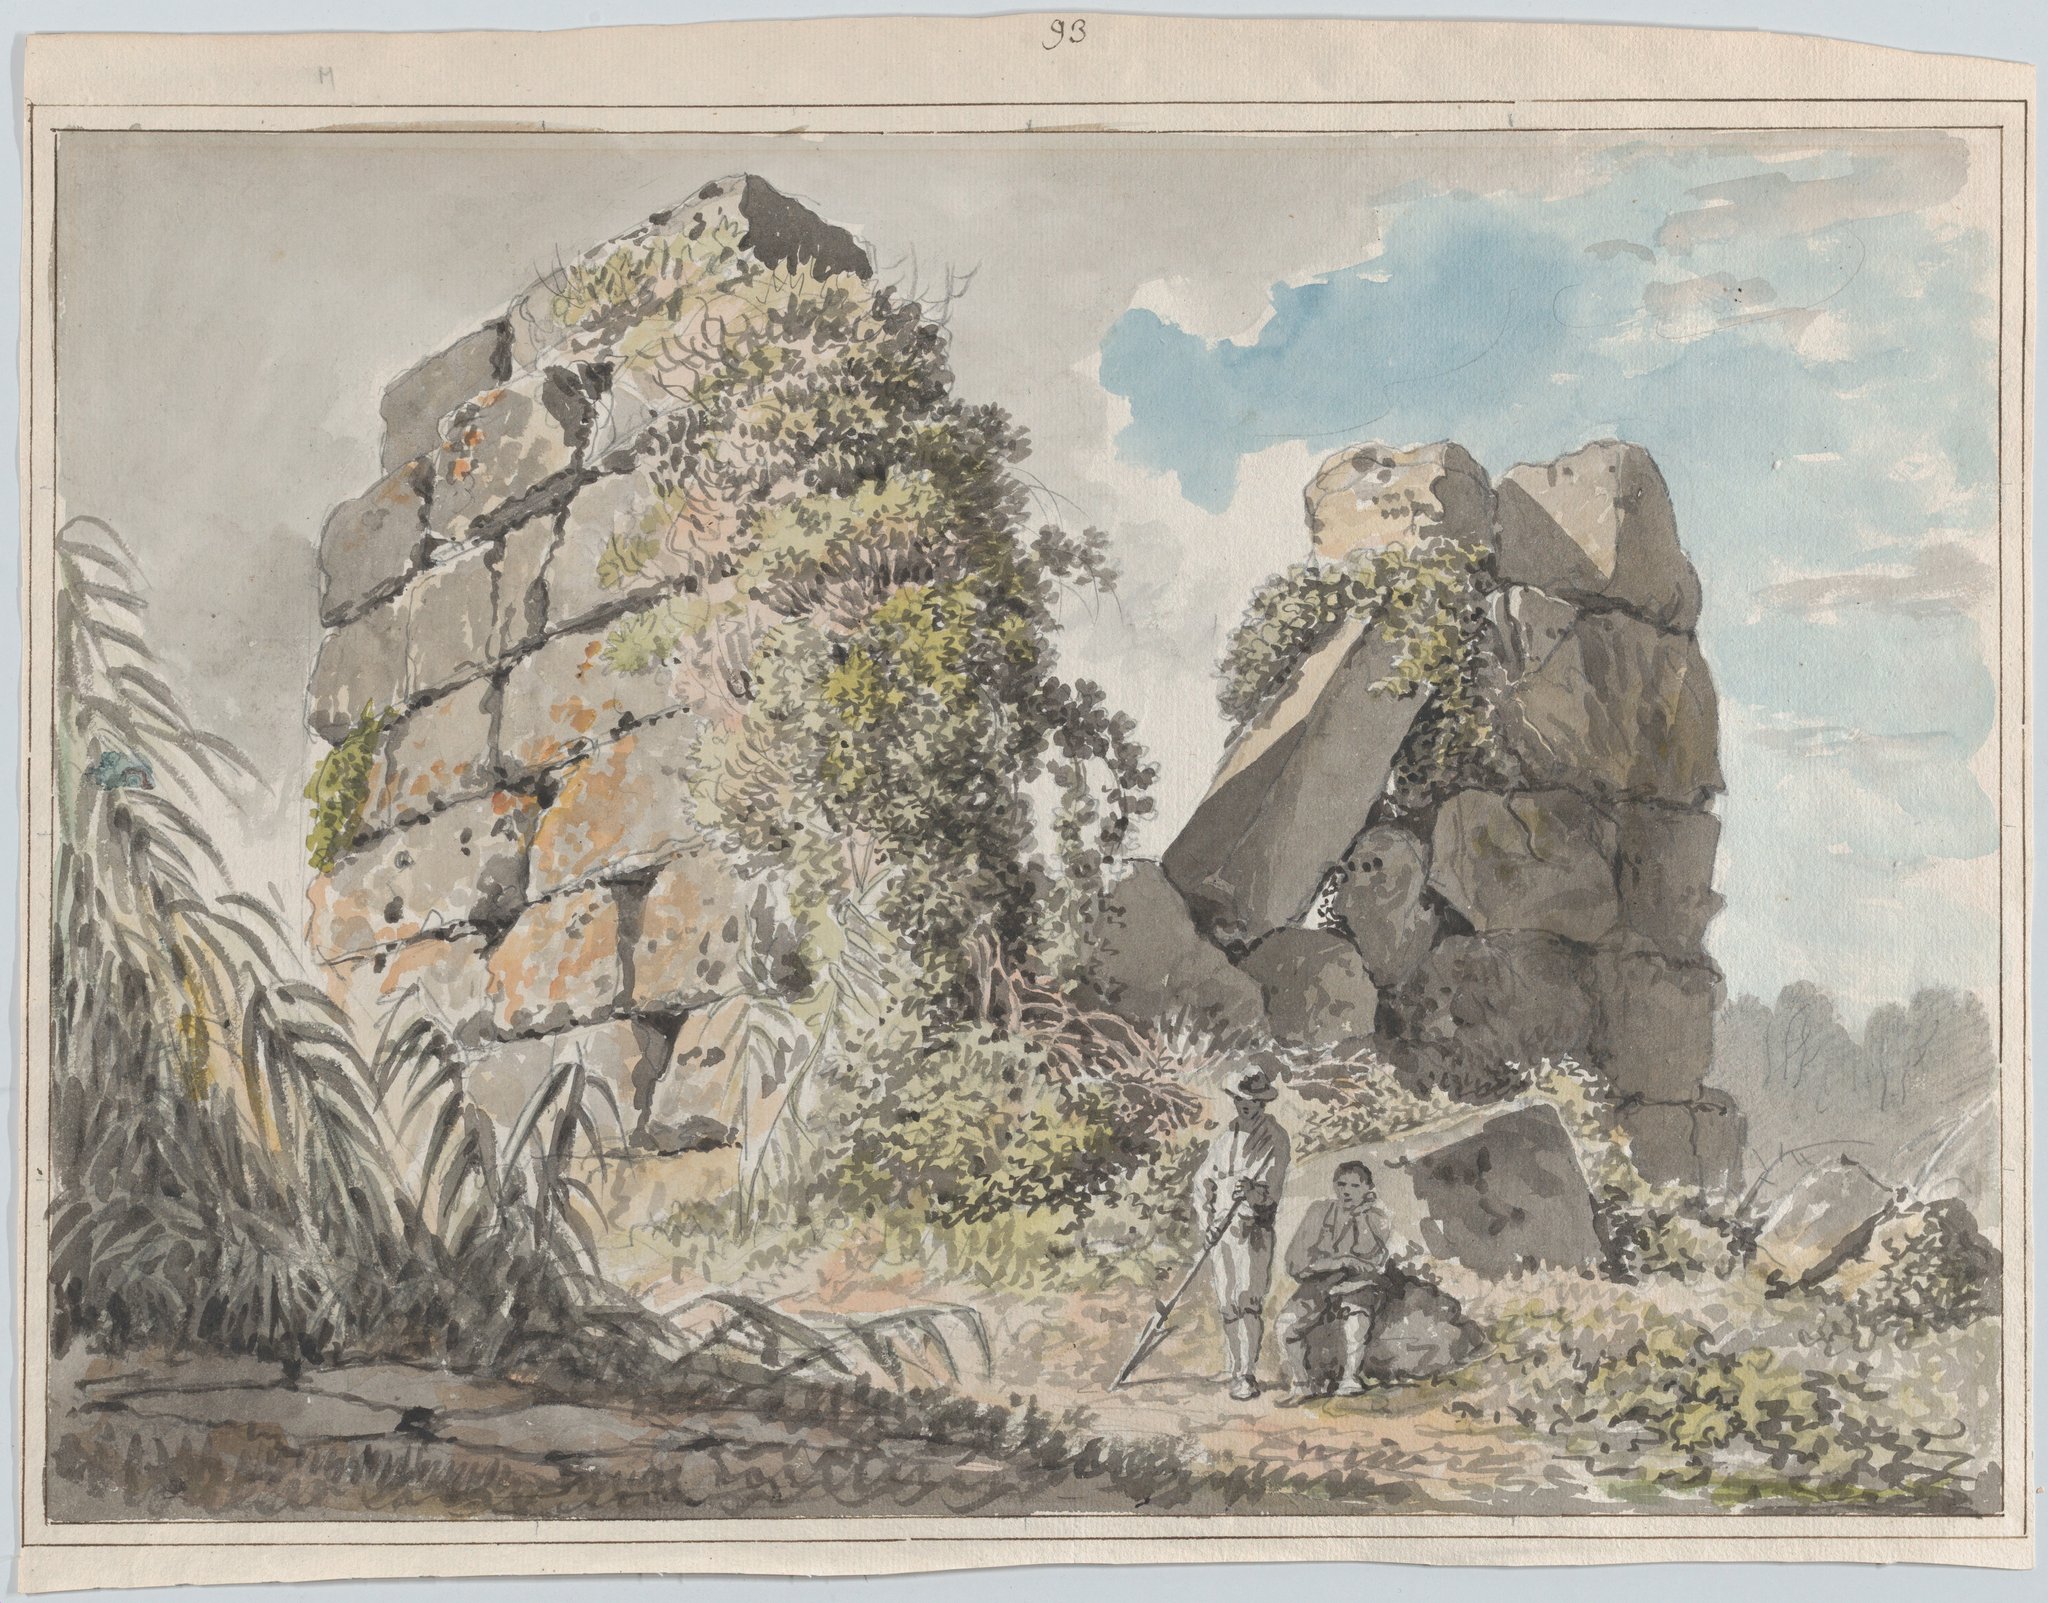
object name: drawing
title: Ruins on the Right of the Via Appia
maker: carlo labruzzi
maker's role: artist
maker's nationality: italian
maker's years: 1748-1818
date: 1789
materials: graphite, watercolor